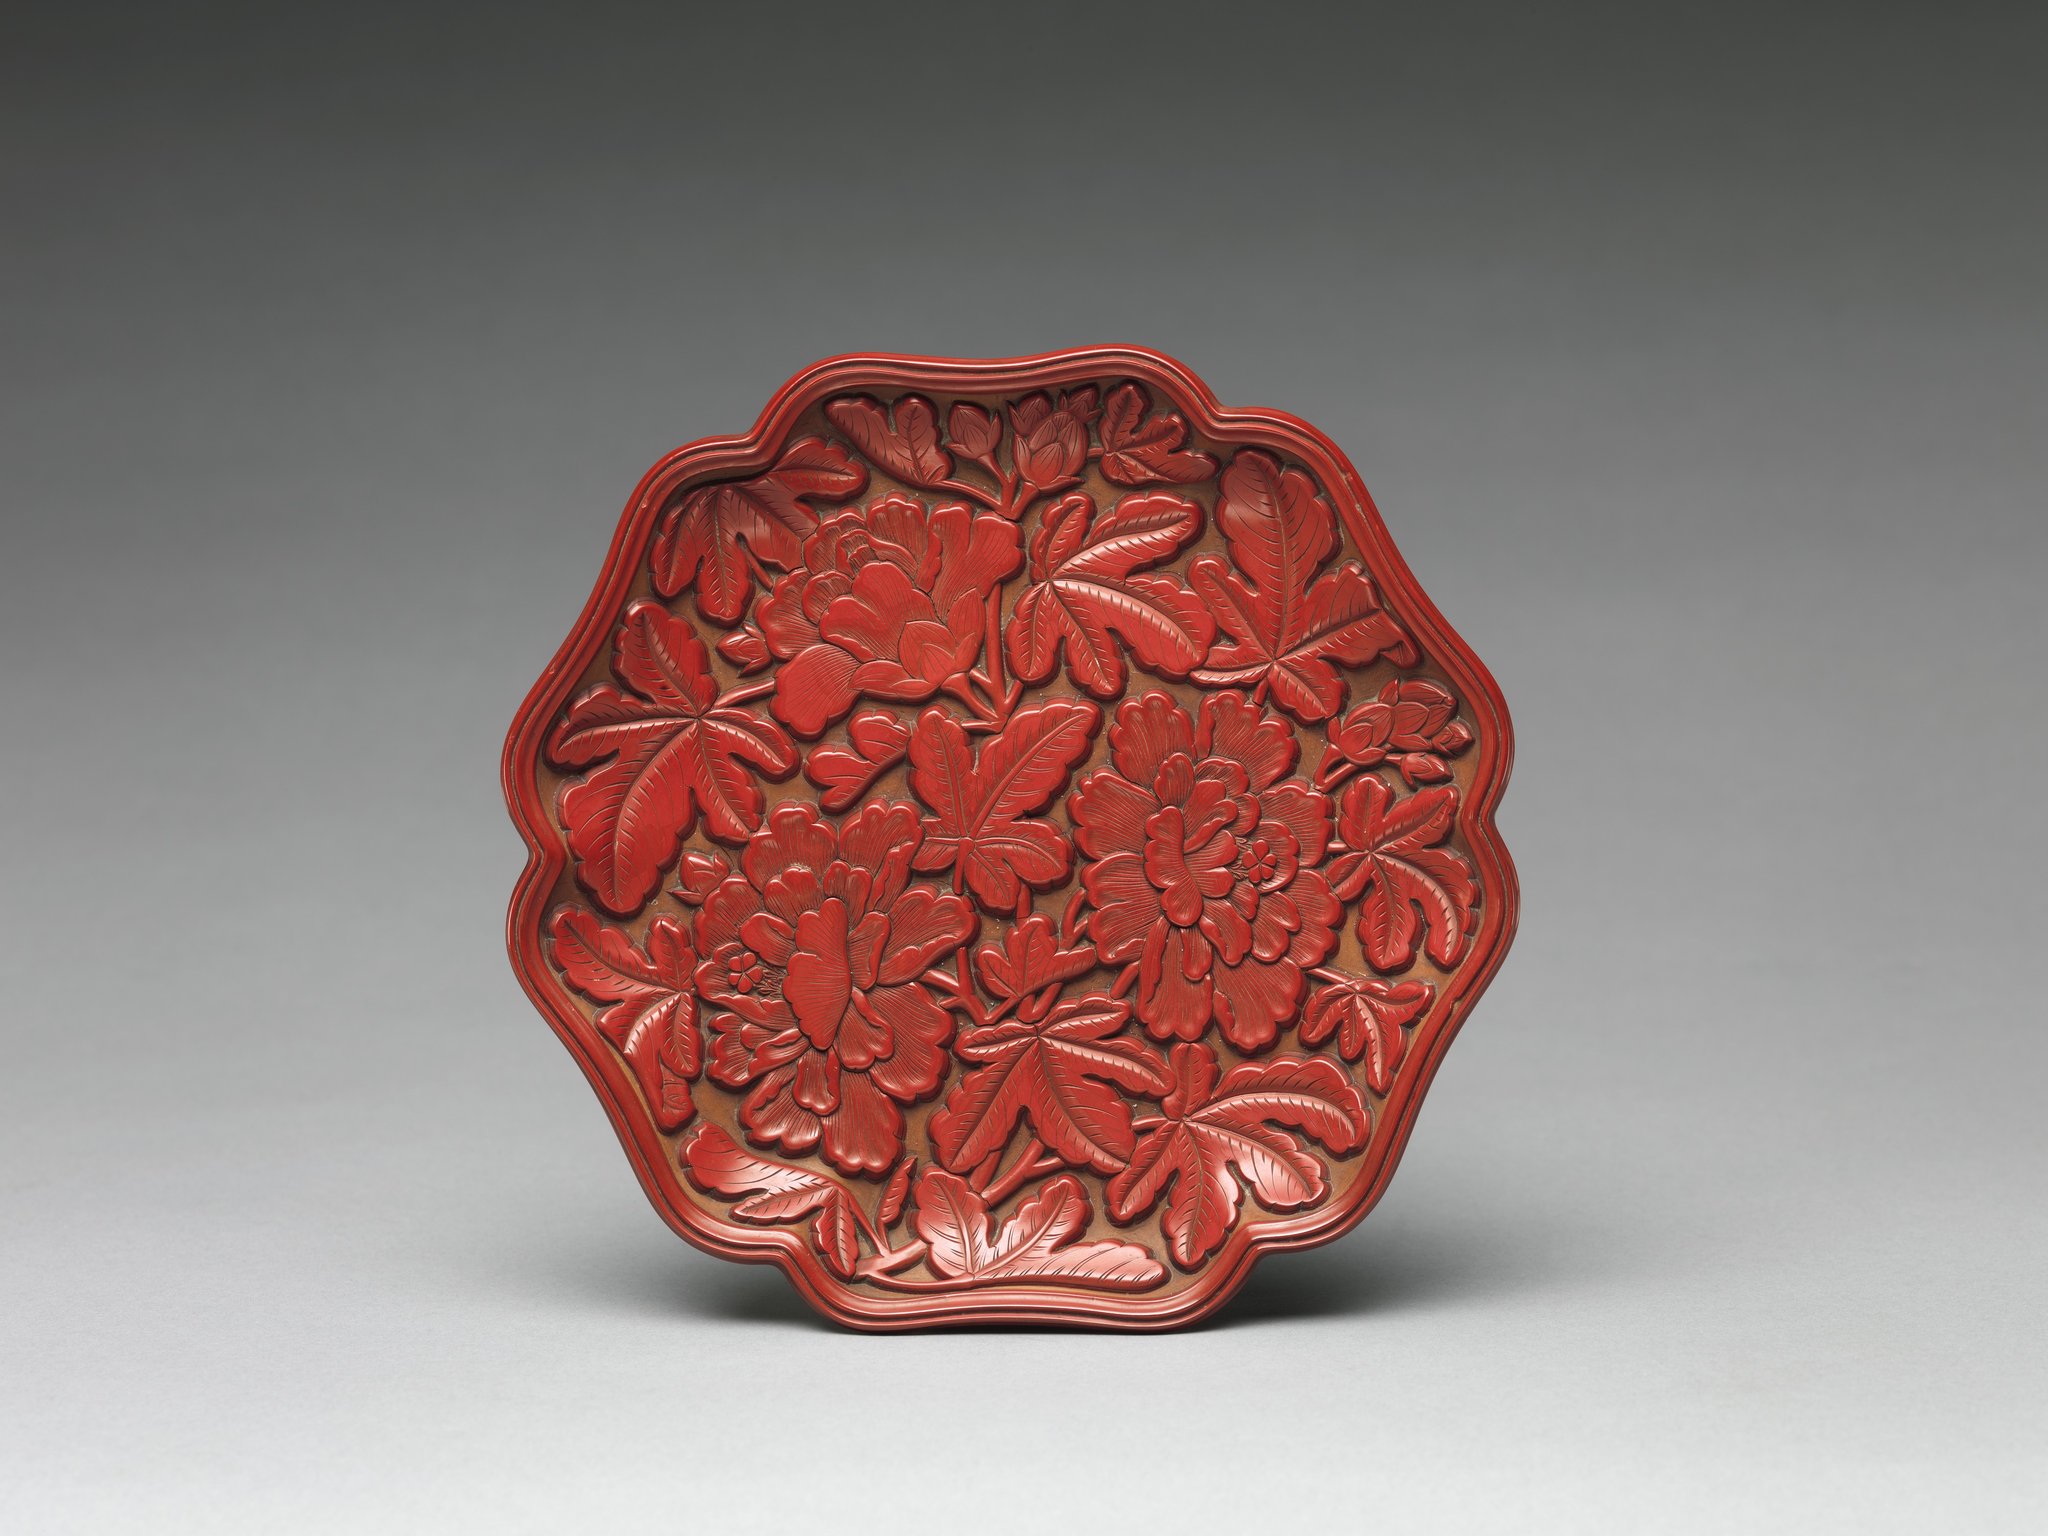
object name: dish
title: Dish with peonies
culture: chinese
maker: yang mao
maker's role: artist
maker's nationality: chinese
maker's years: 1334-1366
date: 1301-1400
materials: lacquer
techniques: carving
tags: peonies